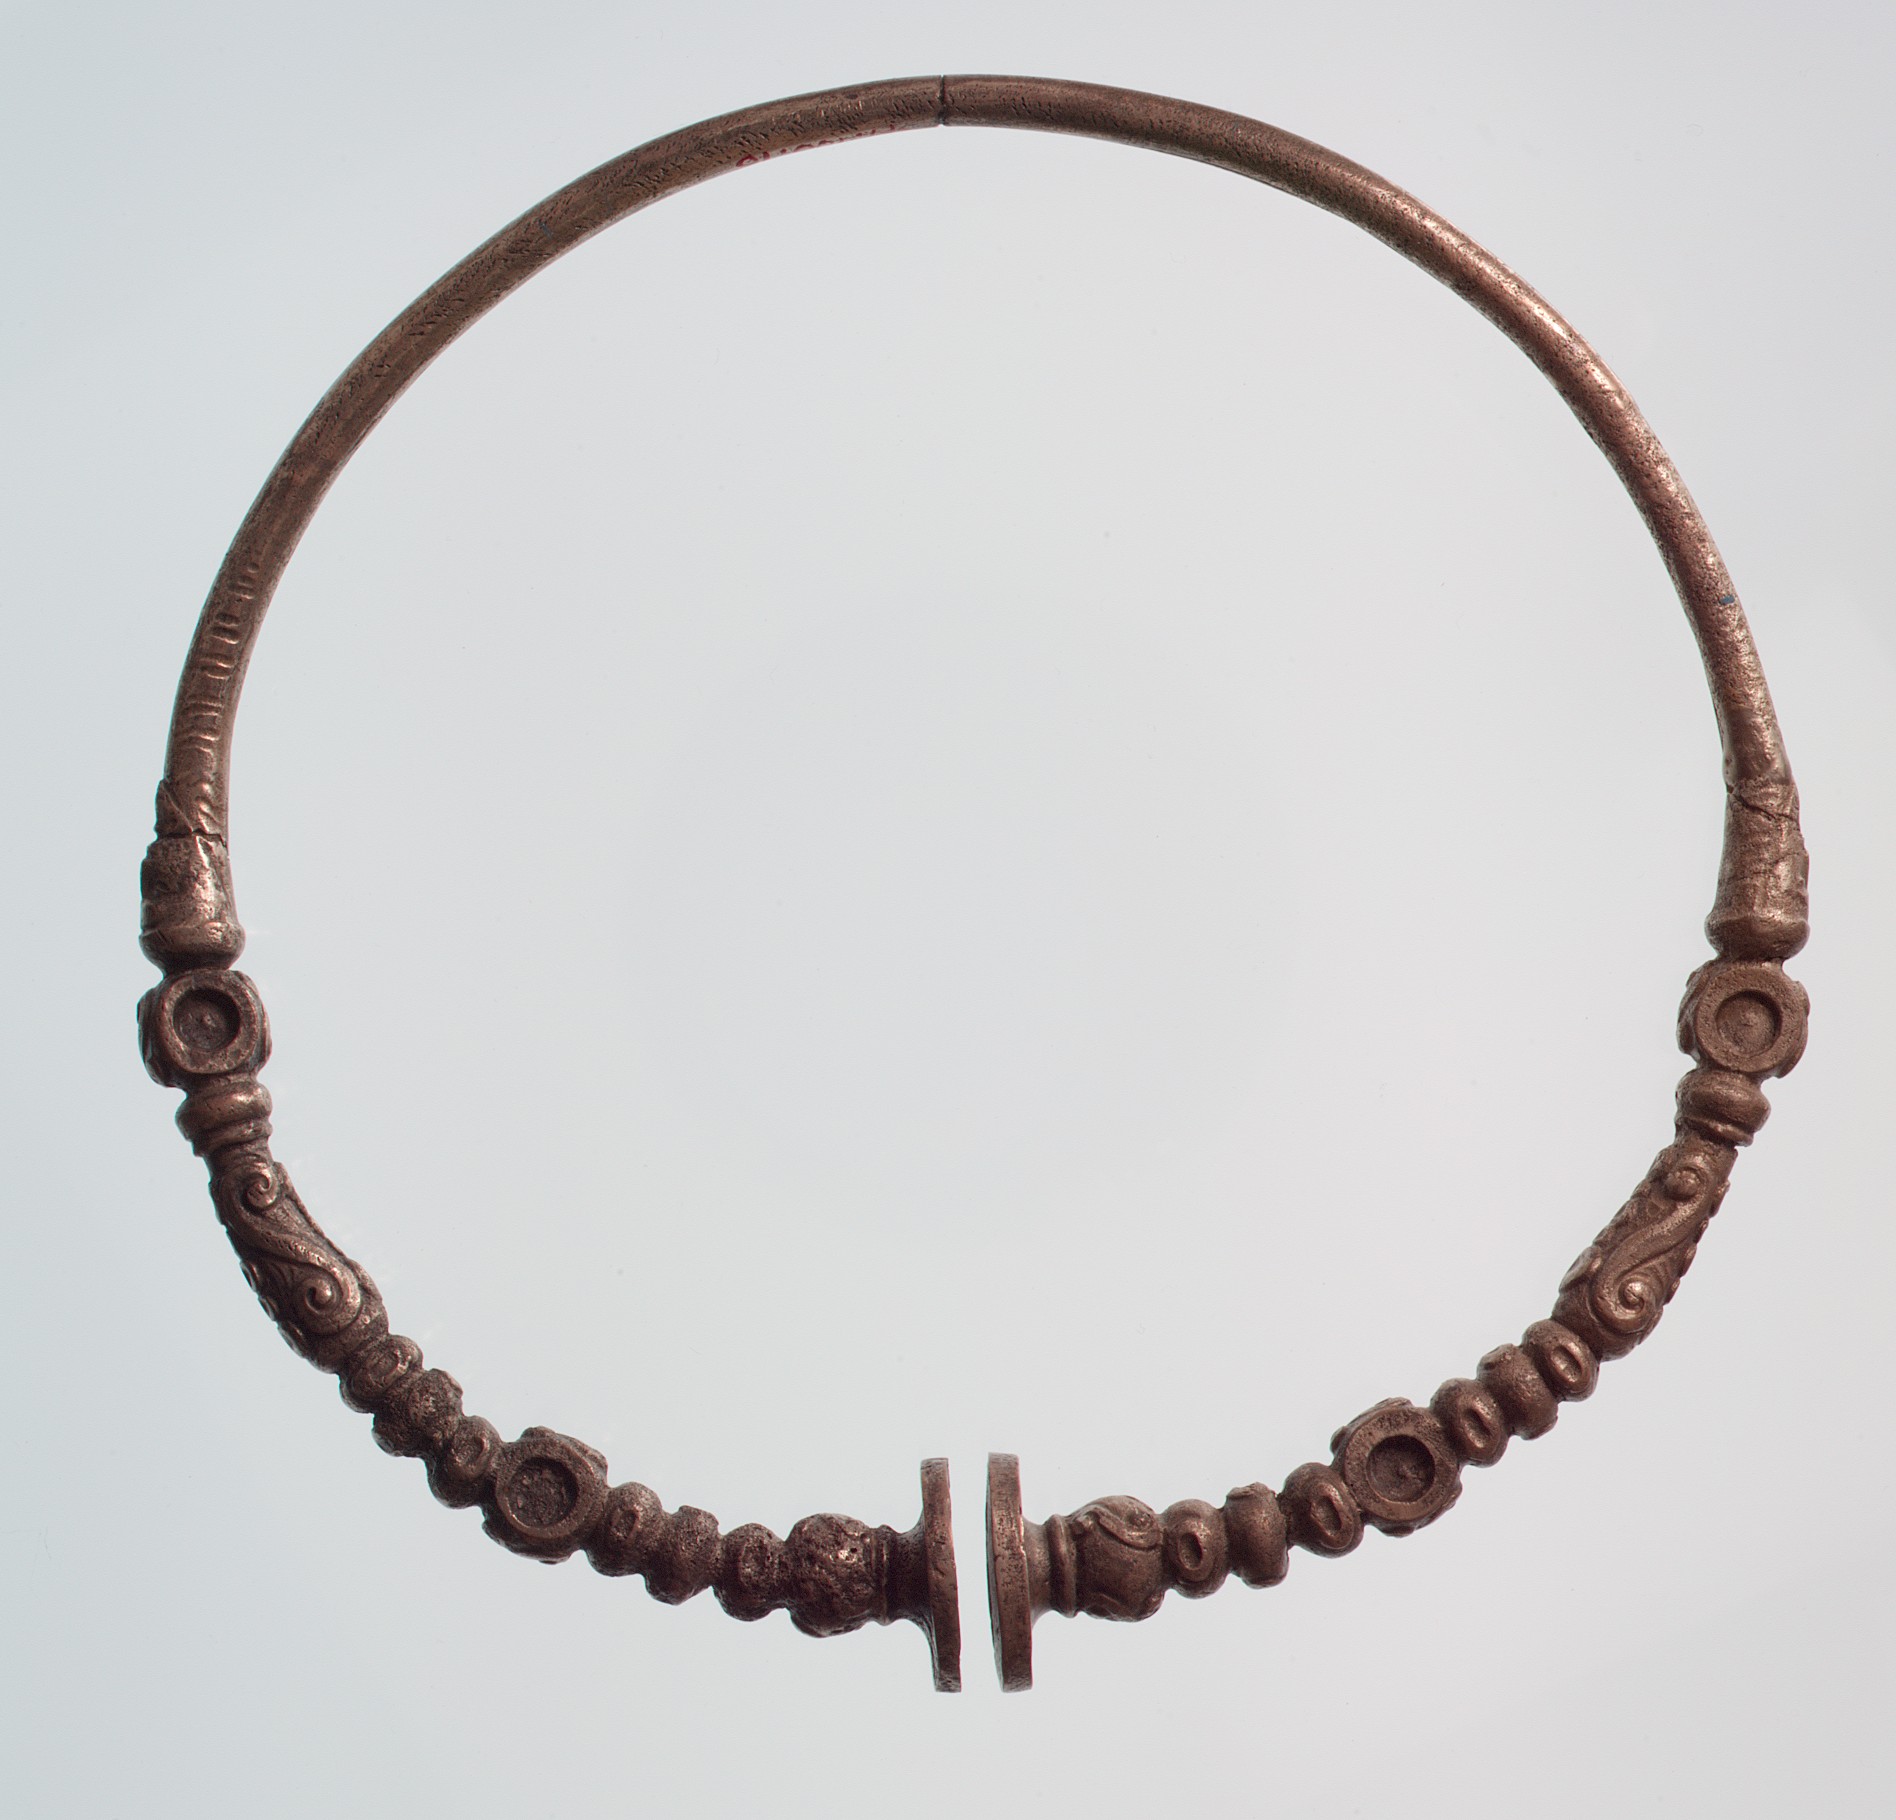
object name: torc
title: Silver Neck Ring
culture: celtic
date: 475-400 BCE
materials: silver